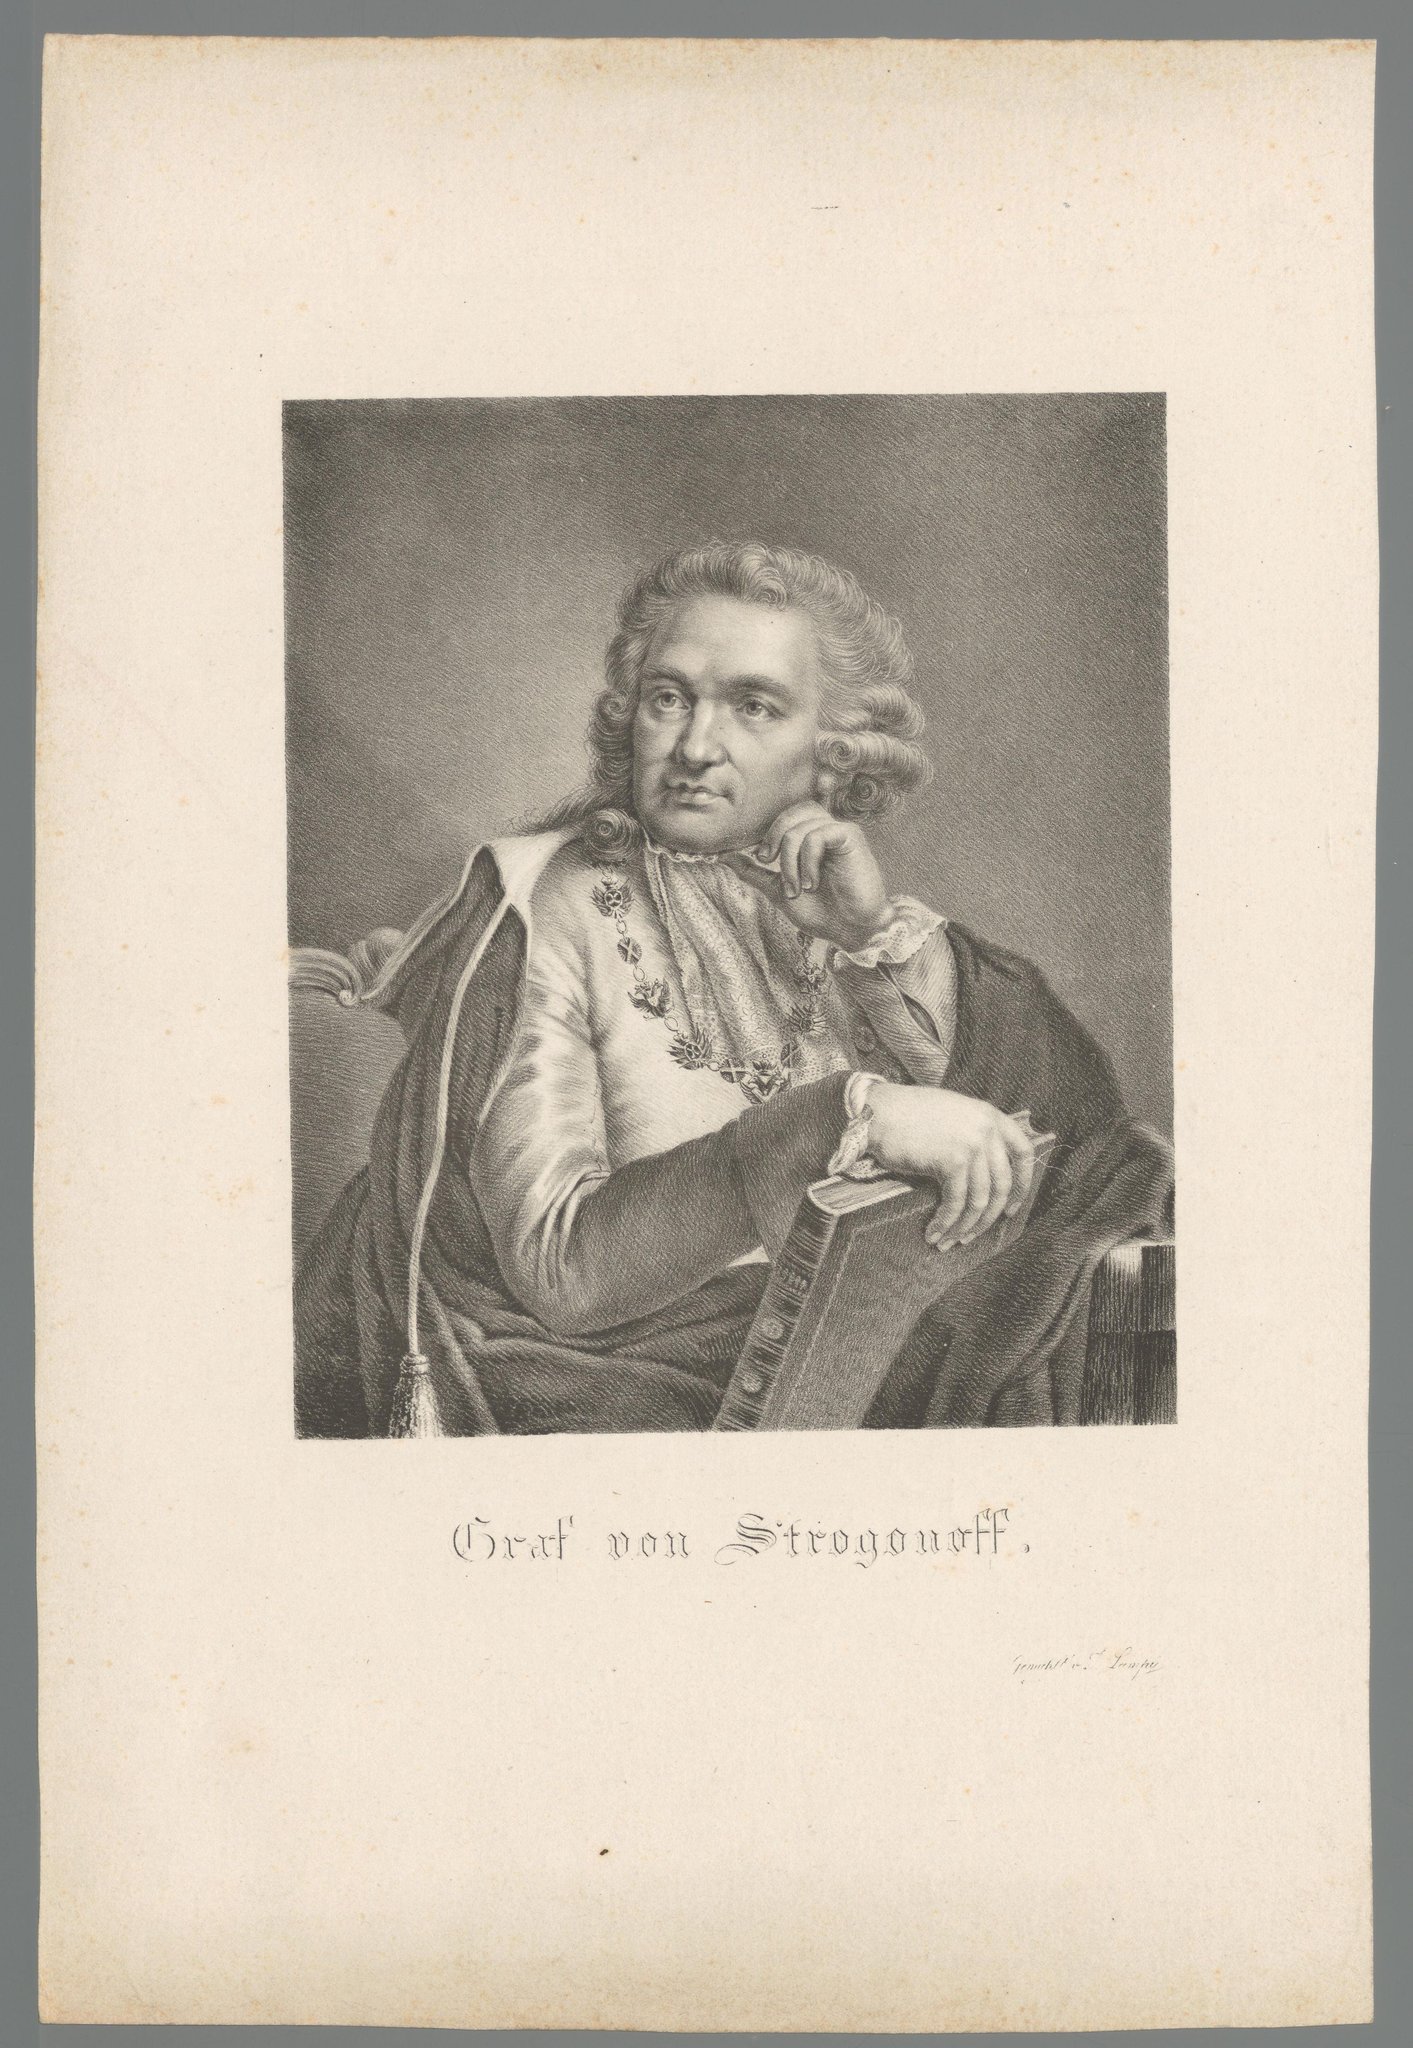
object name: print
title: Graf von Stroganoff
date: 1820-1860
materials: paper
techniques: lithograph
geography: germany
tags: alexander sergeievich graaf stroganoff, adult man, historical persons, book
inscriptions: collector's mark: Lugt 2228